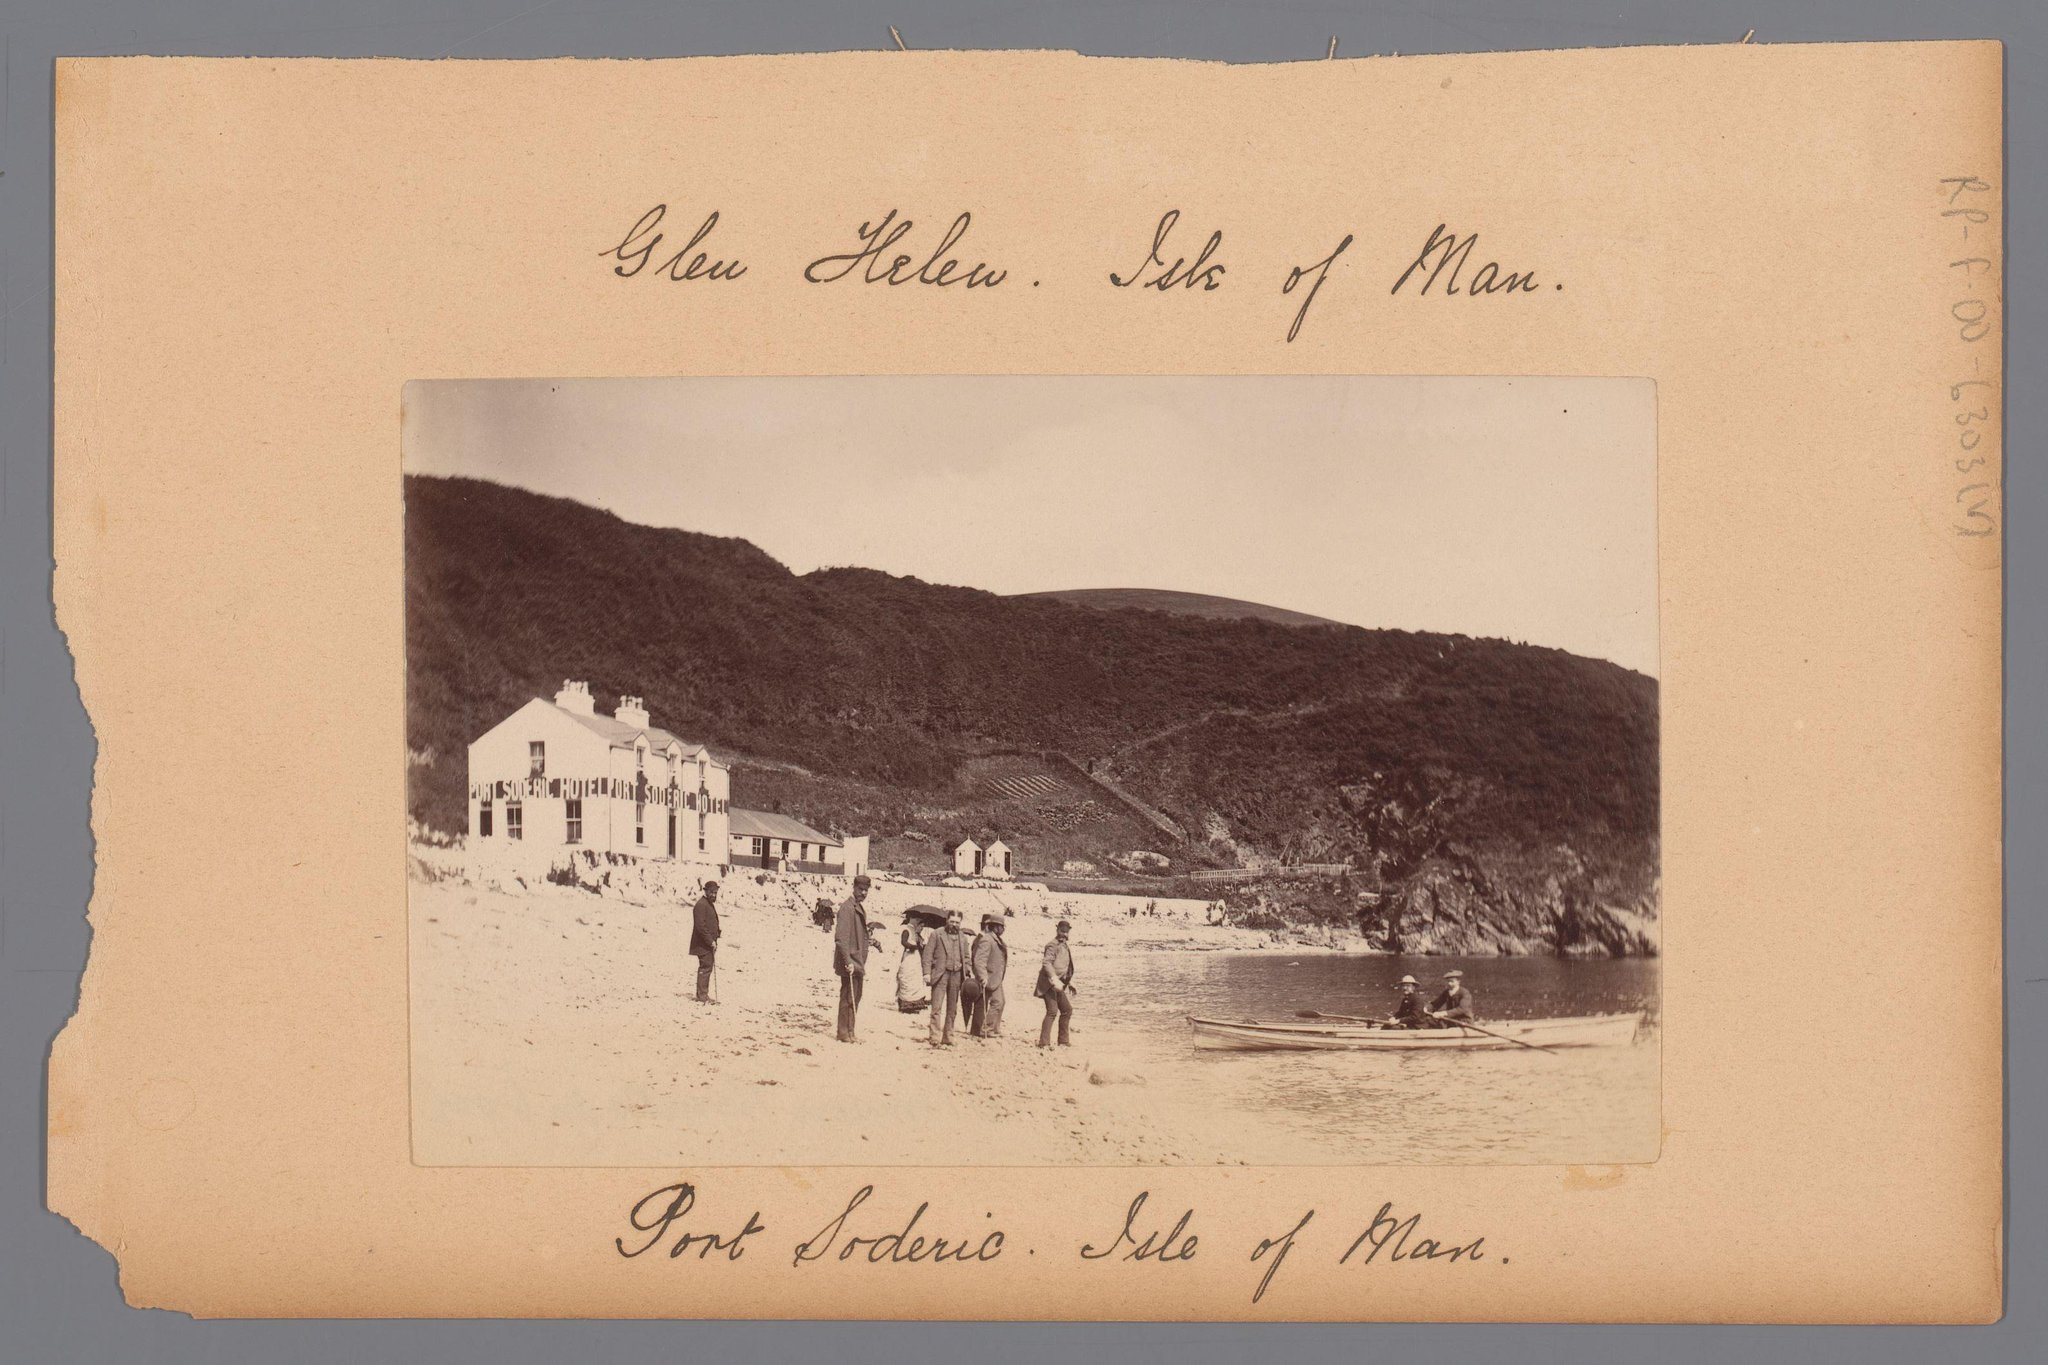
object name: album leaf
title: Glen Helen, Port Soderick, Isle of Man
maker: Anonymous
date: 1880-1900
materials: cardboard, paper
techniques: albumen print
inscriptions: inscription: ‘Glen Helen. Isle of Man.//Port Soderic [sic]. Isle of Man’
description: Uitzicht opheuvels, links Hotel Soderic, op de voorgrond een strand met een aantal mensen en twee mannen in een roeiboot rechts.